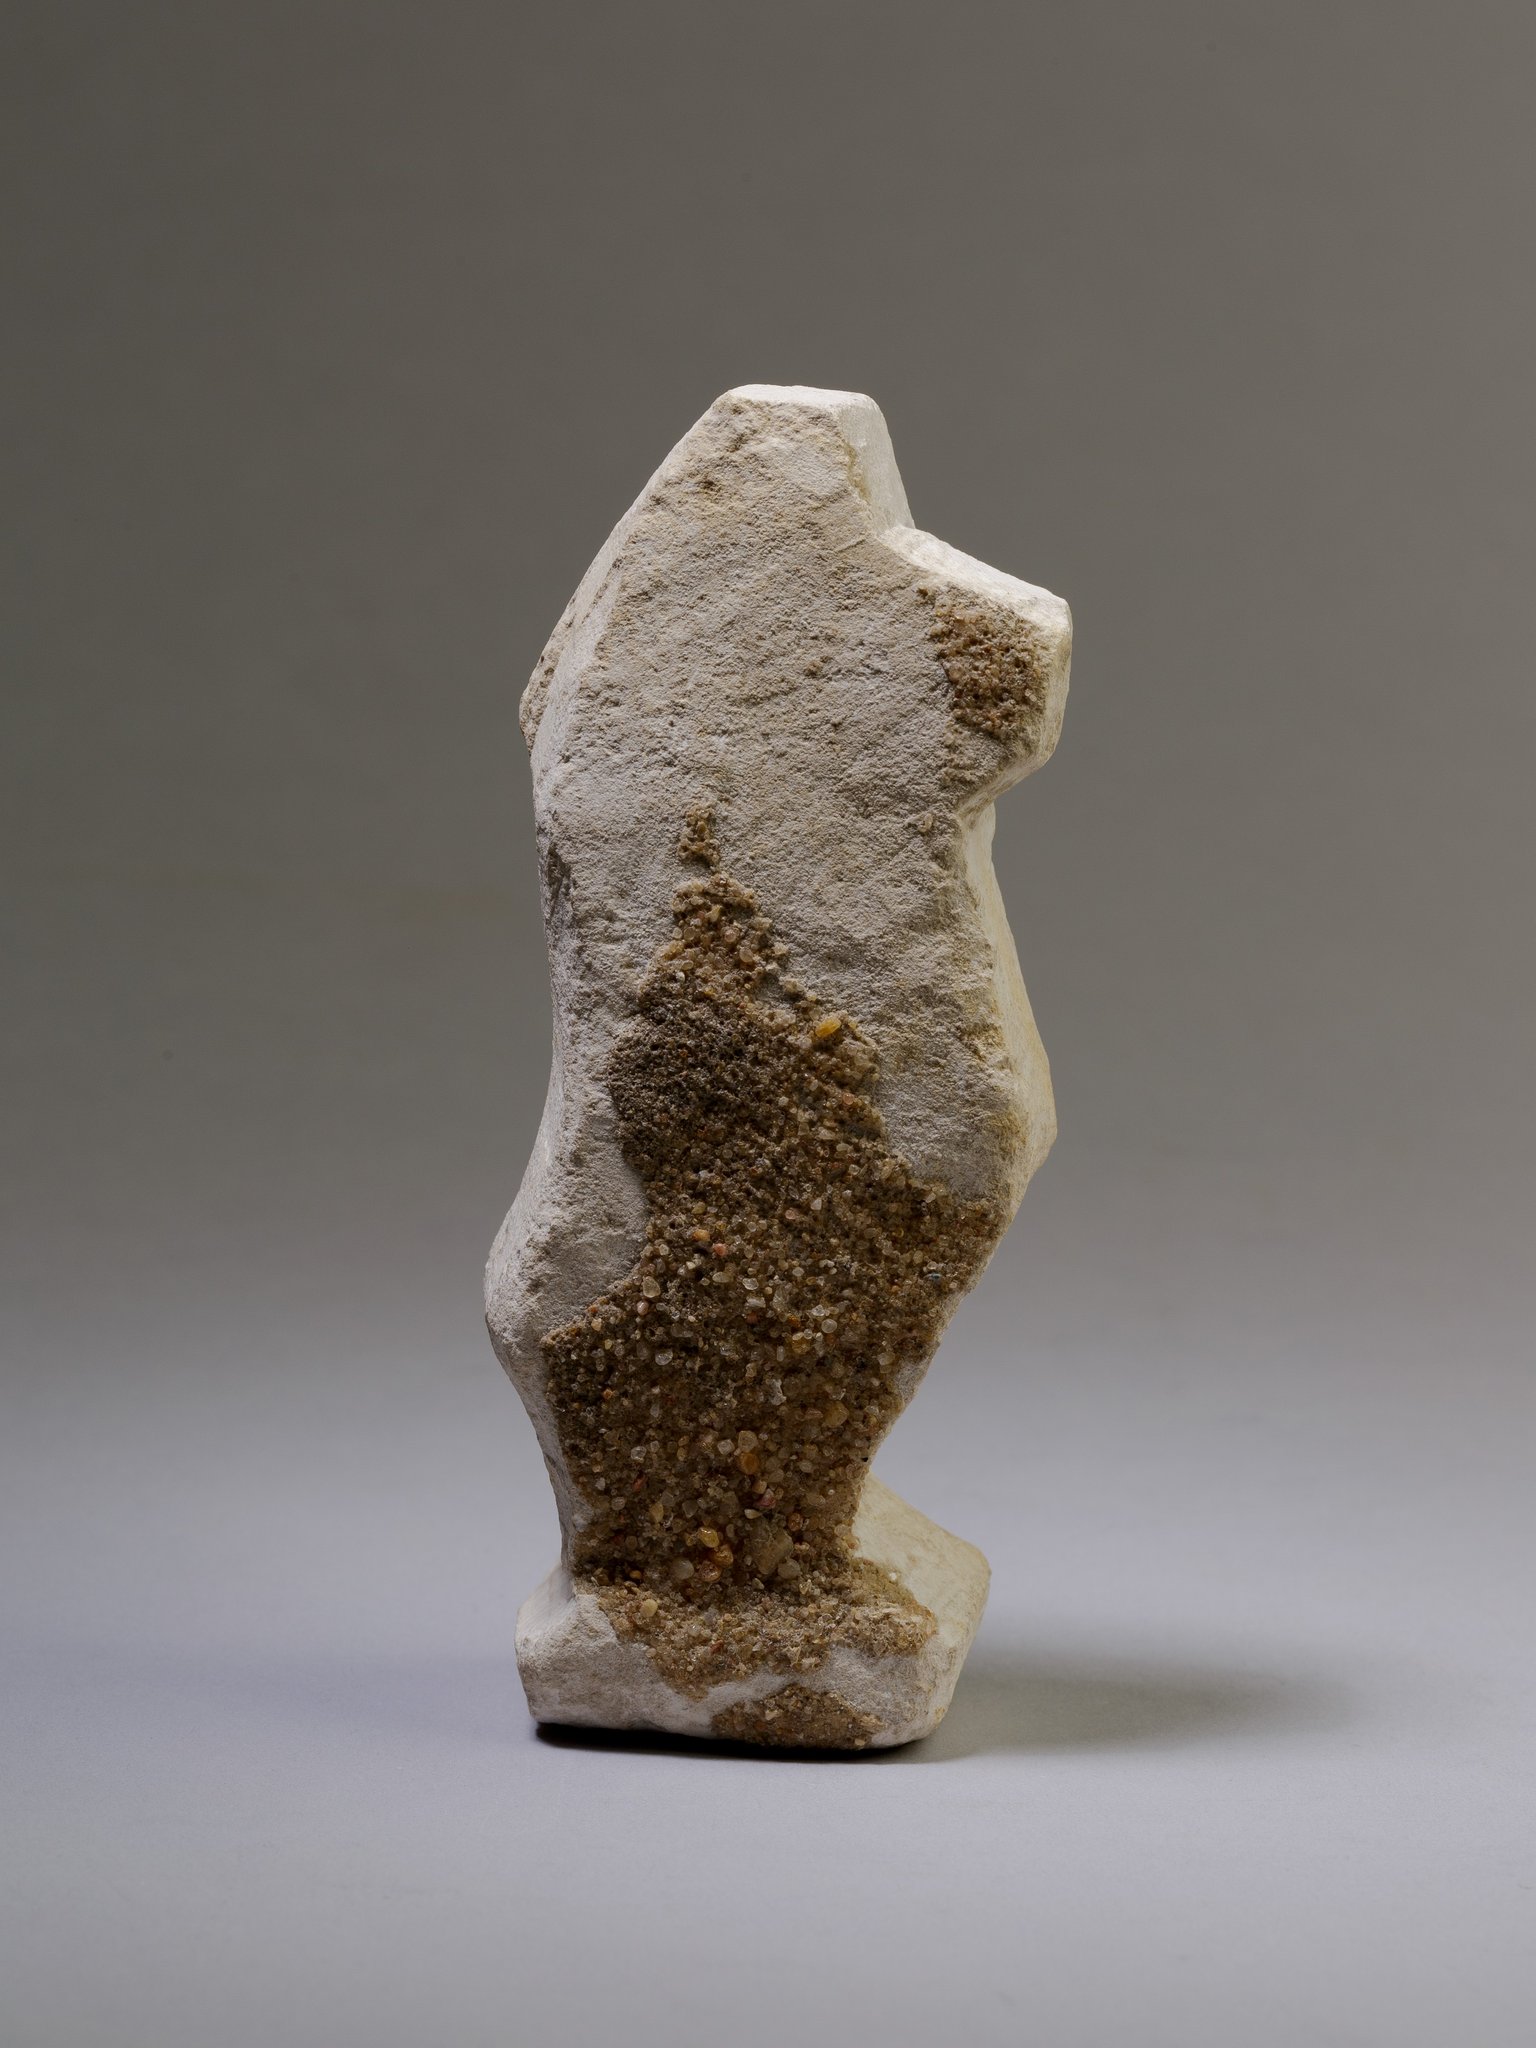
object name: figurine, taweret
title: Taweret figurine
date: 1981-1640 BCE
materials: limestone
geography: egypt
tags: taweret